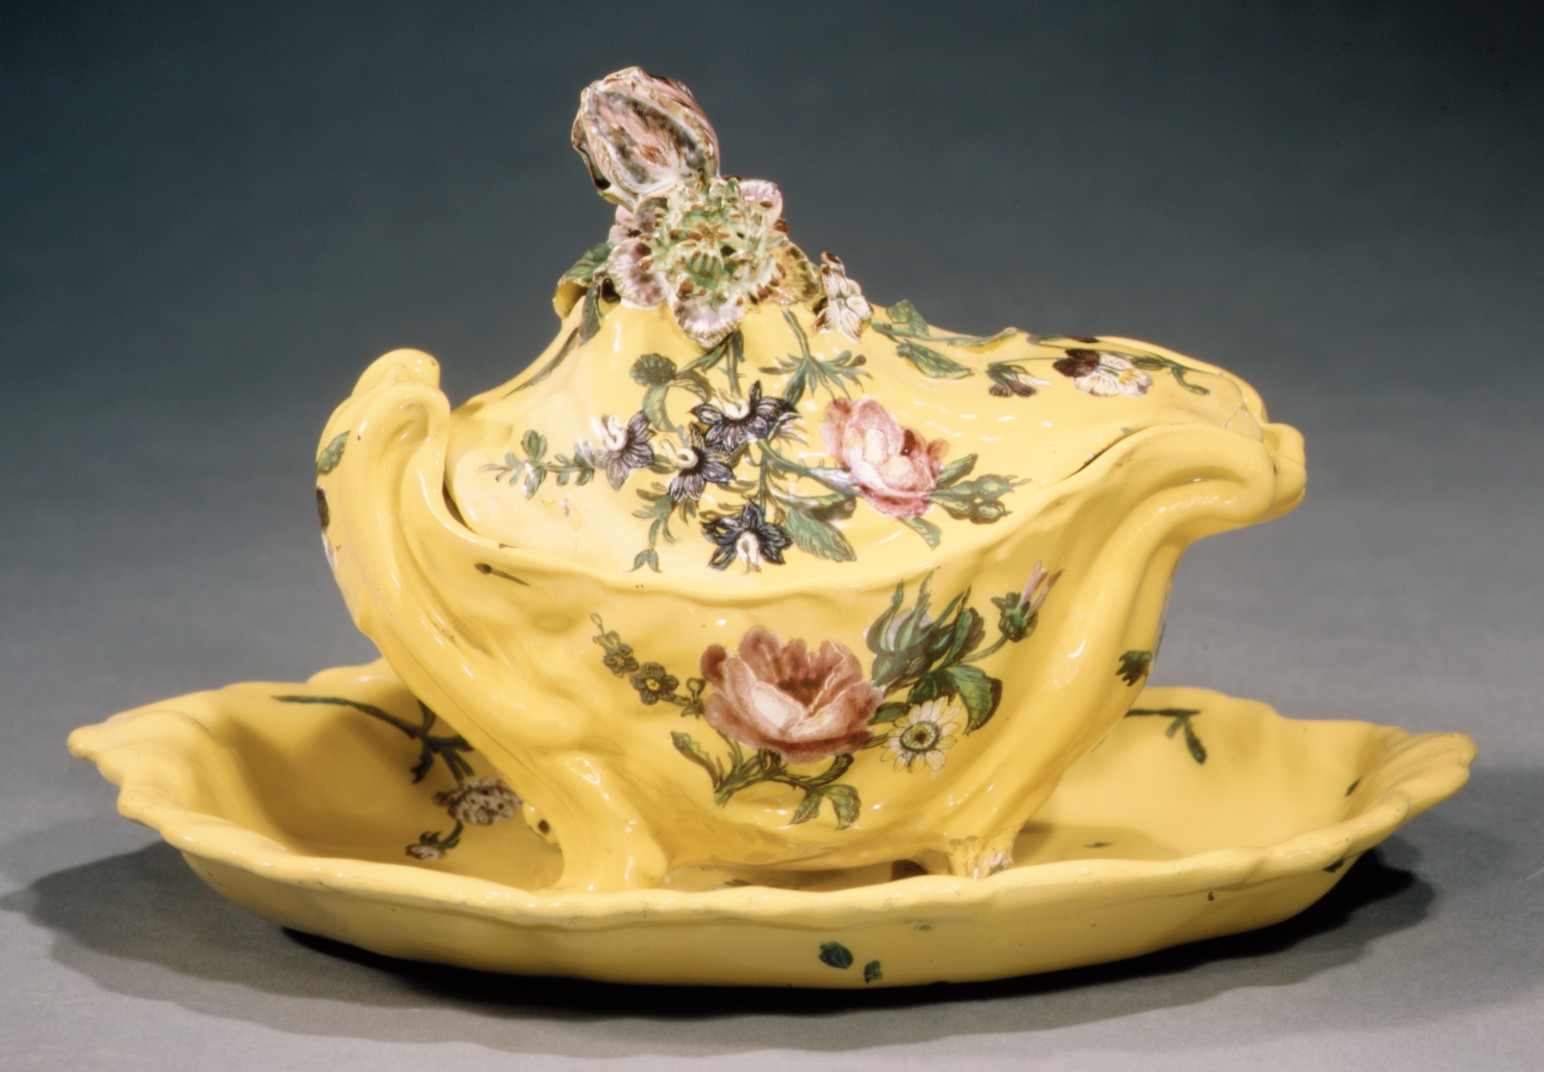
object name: sugar bowl and tray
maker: veuve perrin factory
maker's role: factory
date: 1760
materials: faience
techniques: glazing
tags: flowers